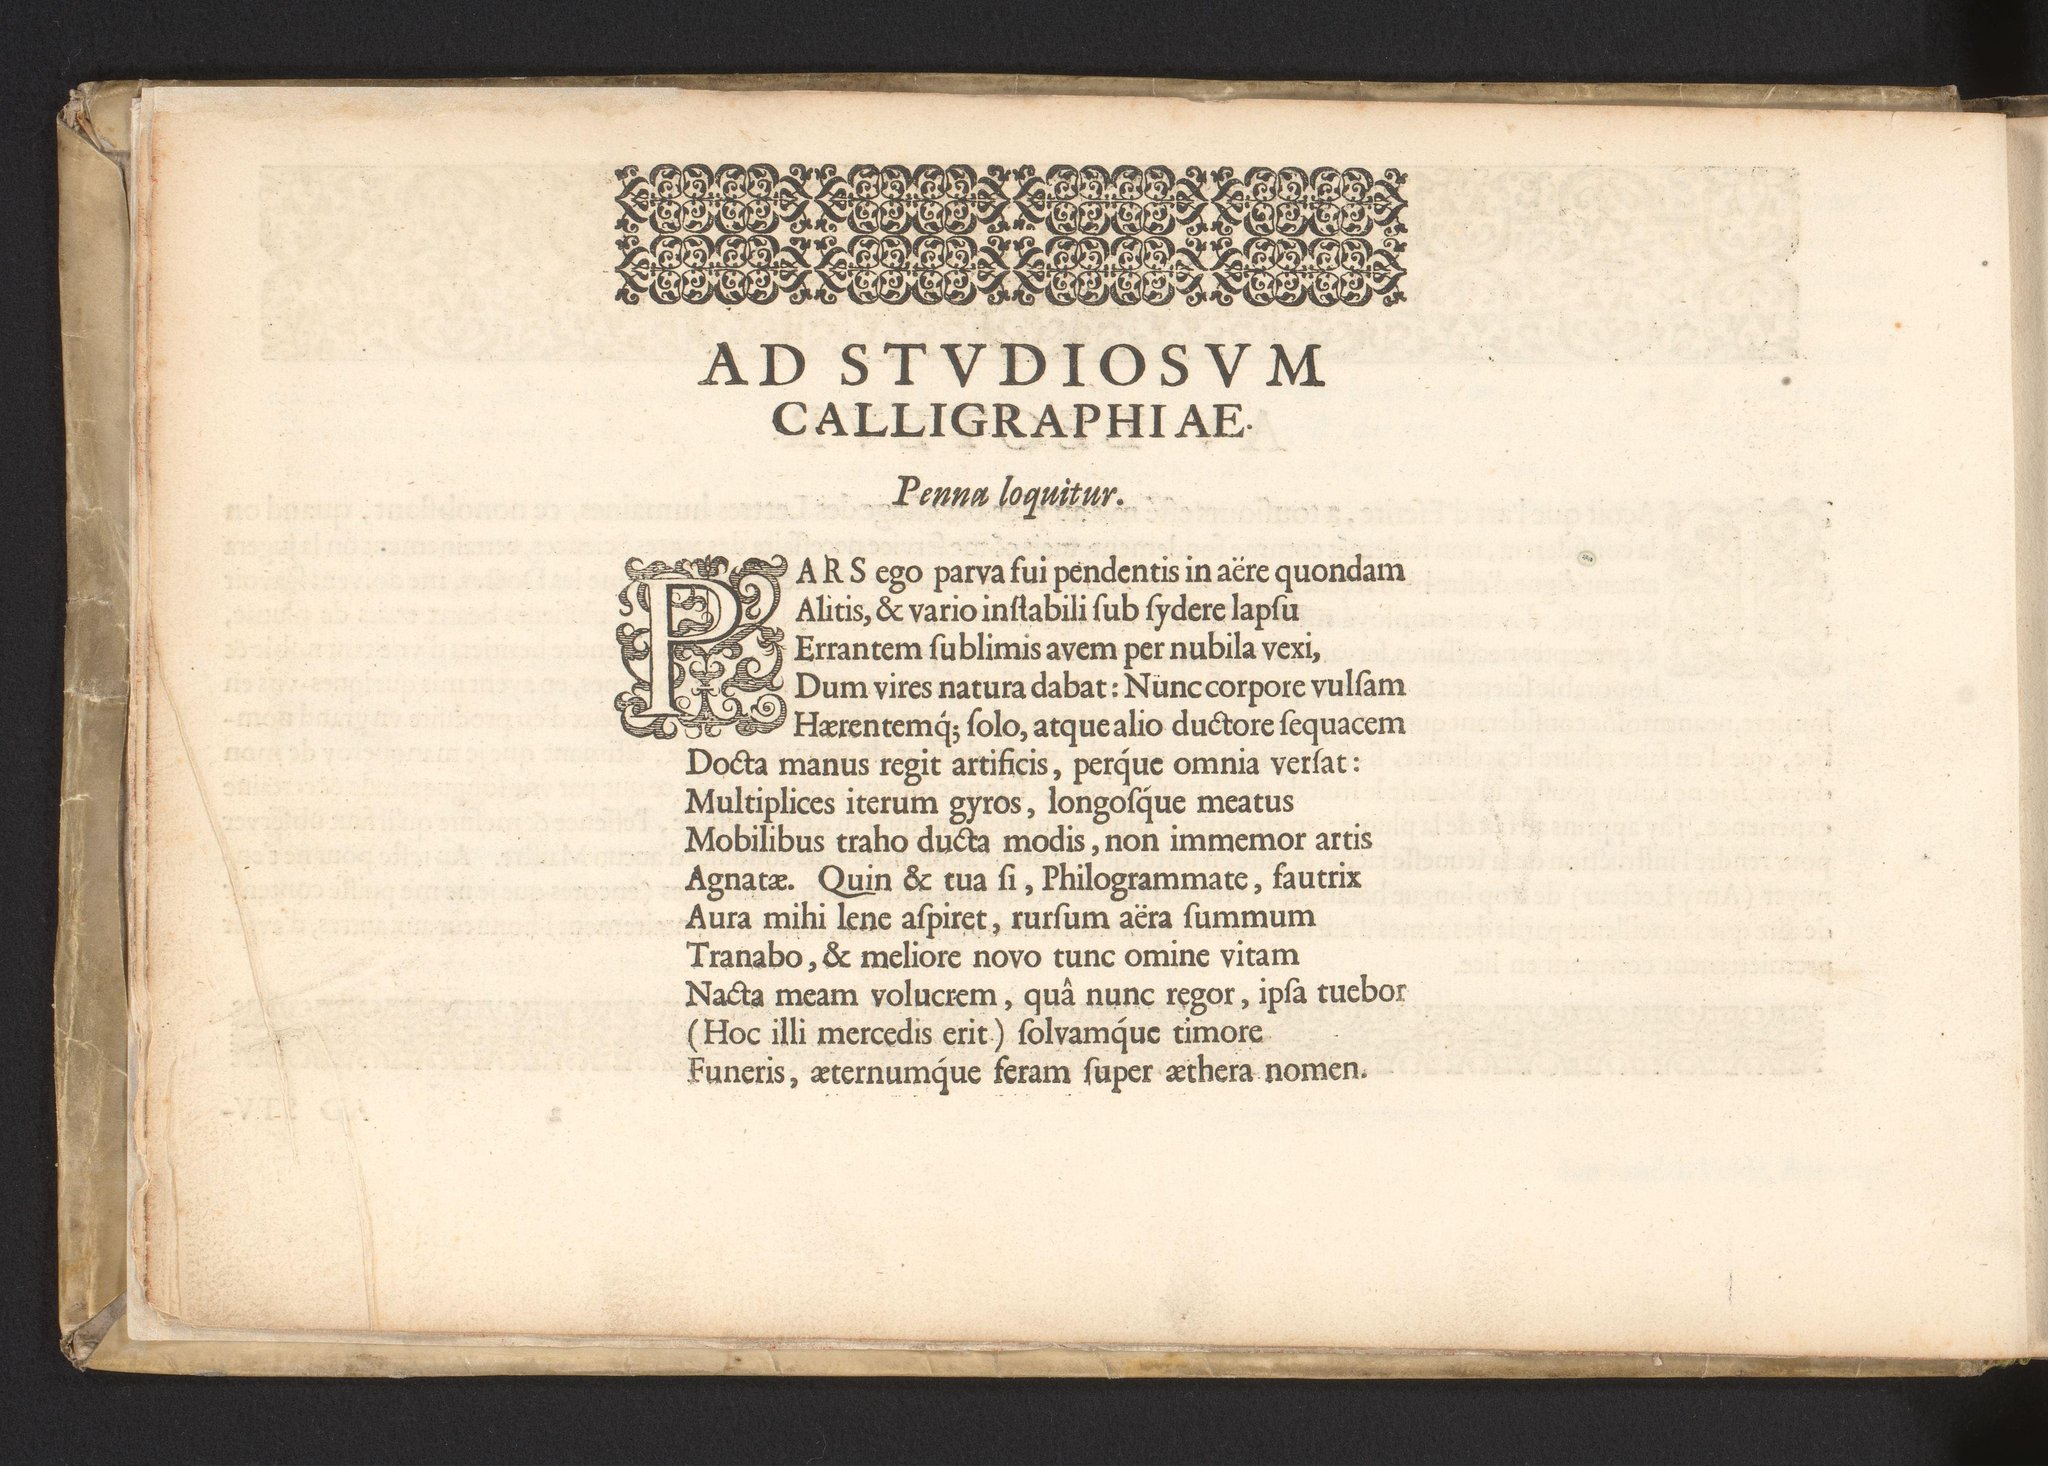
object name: album leaf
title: Latijns gedicht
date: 1605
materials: paper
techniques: letterpress printing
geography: rotterdam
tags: initial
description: Tekstblad met een Latijns gedicht getiteld: Ad studiosum calligraphiae. De tekst begint met een gedecoreerde initiaal P. Bovenaan een ornamentrand van fleurons. Het tekstblad maakt deel uit van een album.